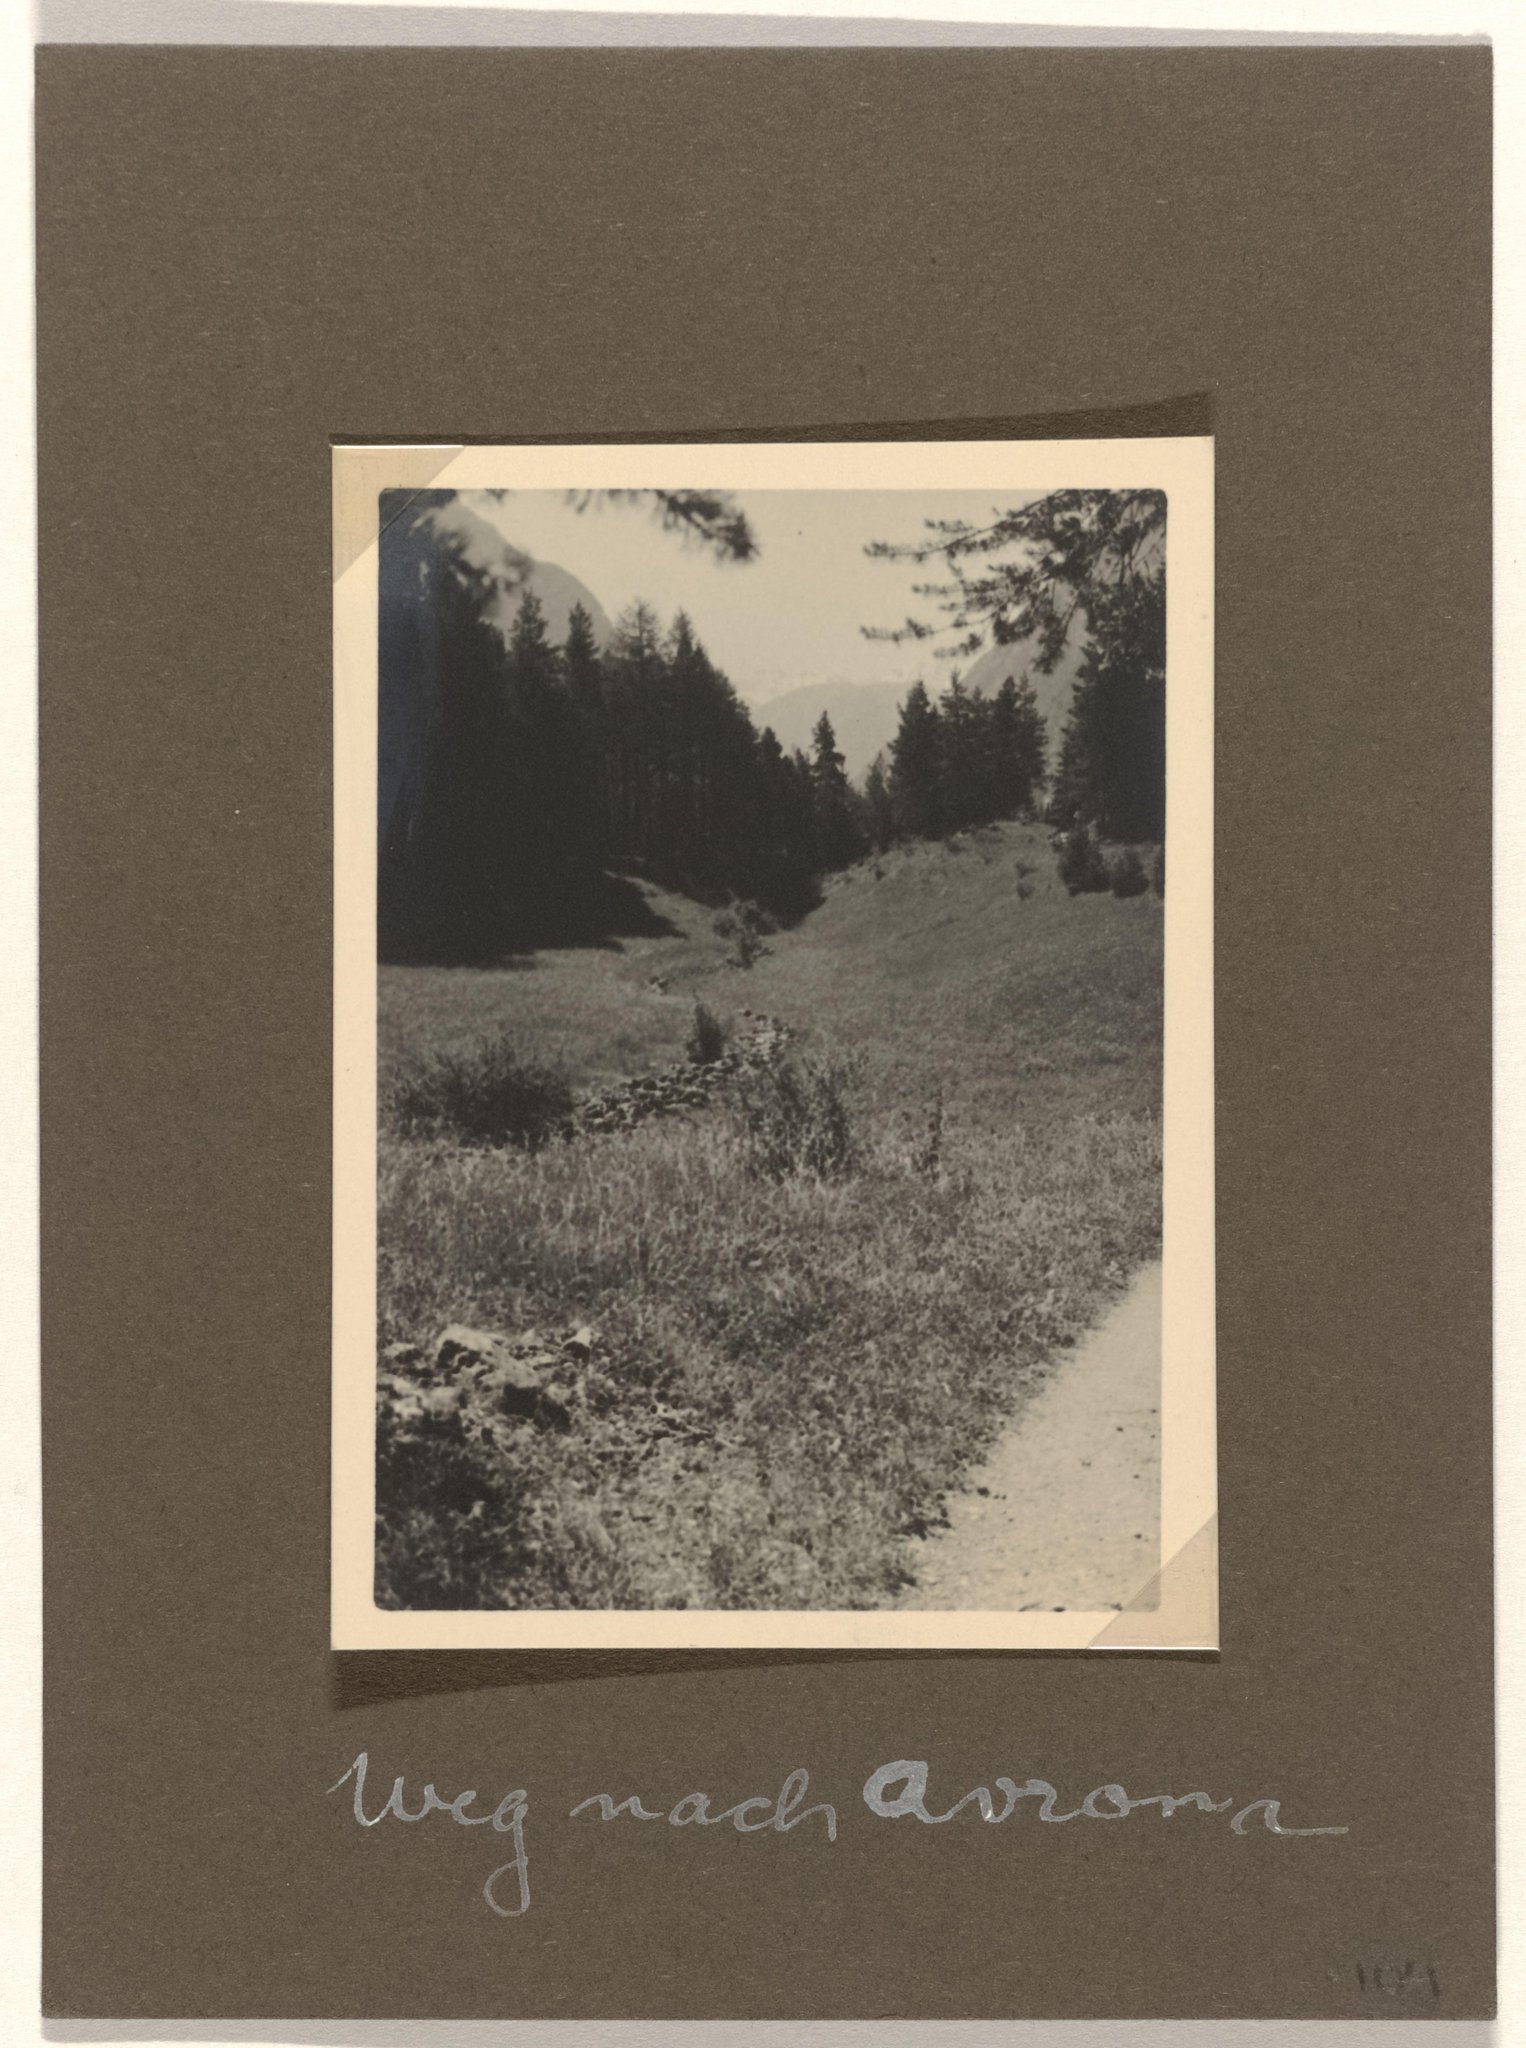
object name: photograph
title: Zicht op de weg naar Avrona, juni-juli 1934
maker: Anonymous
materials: photographic support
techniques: gelatin silver print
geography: switzerland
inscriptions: inscription: ‘weg nach Avrona’